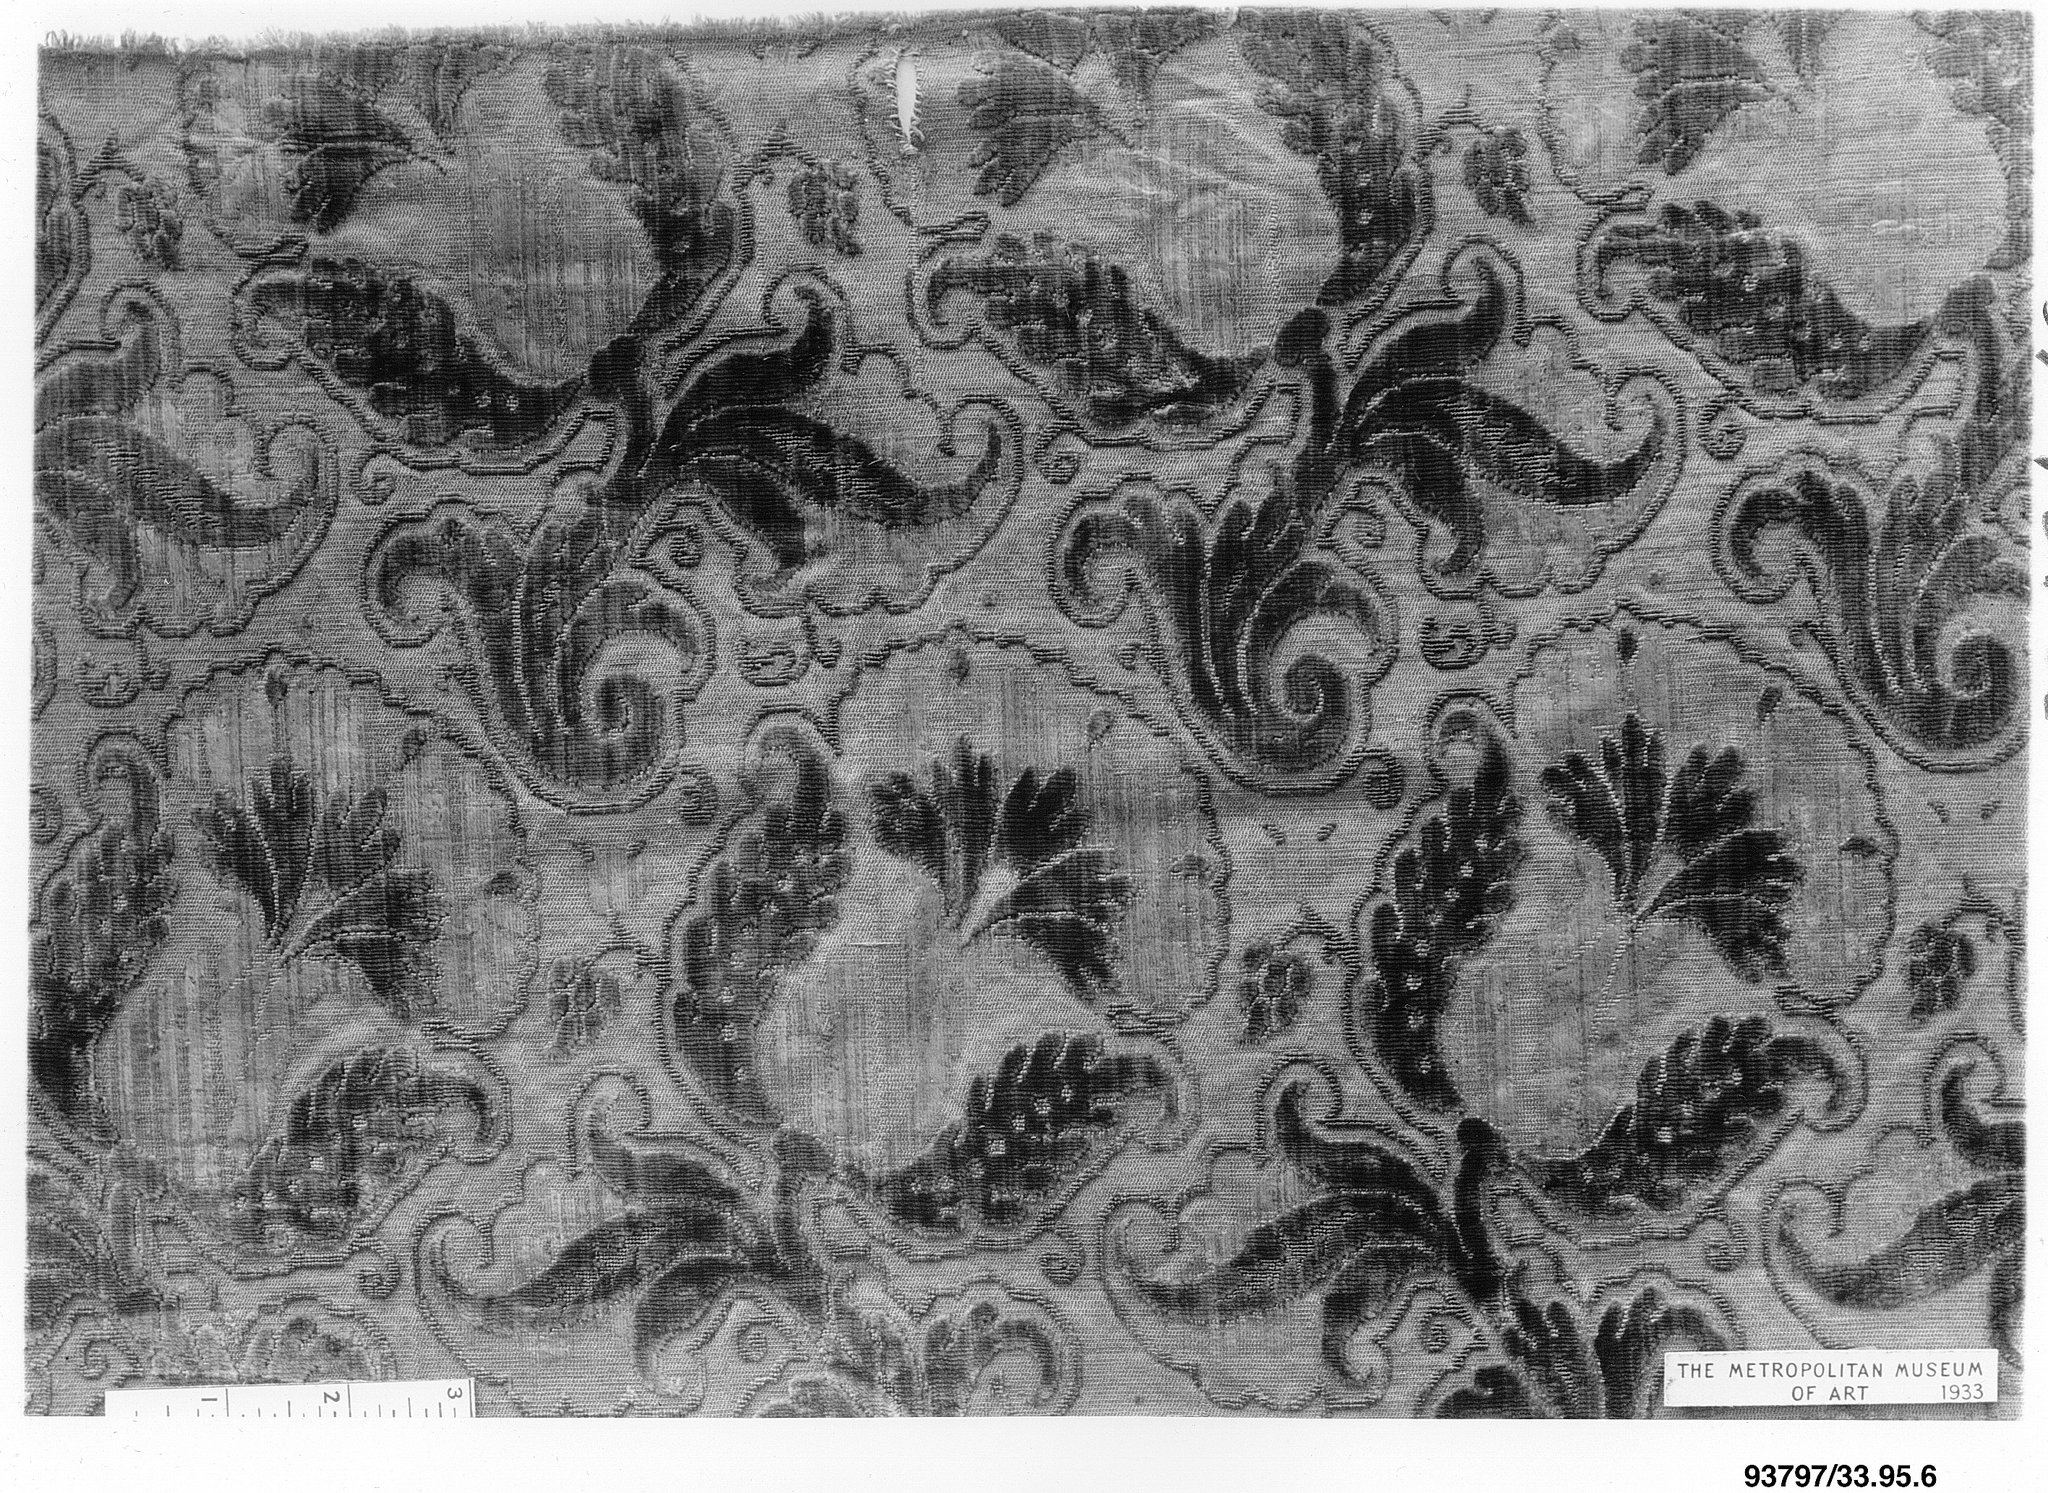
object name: piece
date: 1601-1700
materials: metal thread, silk